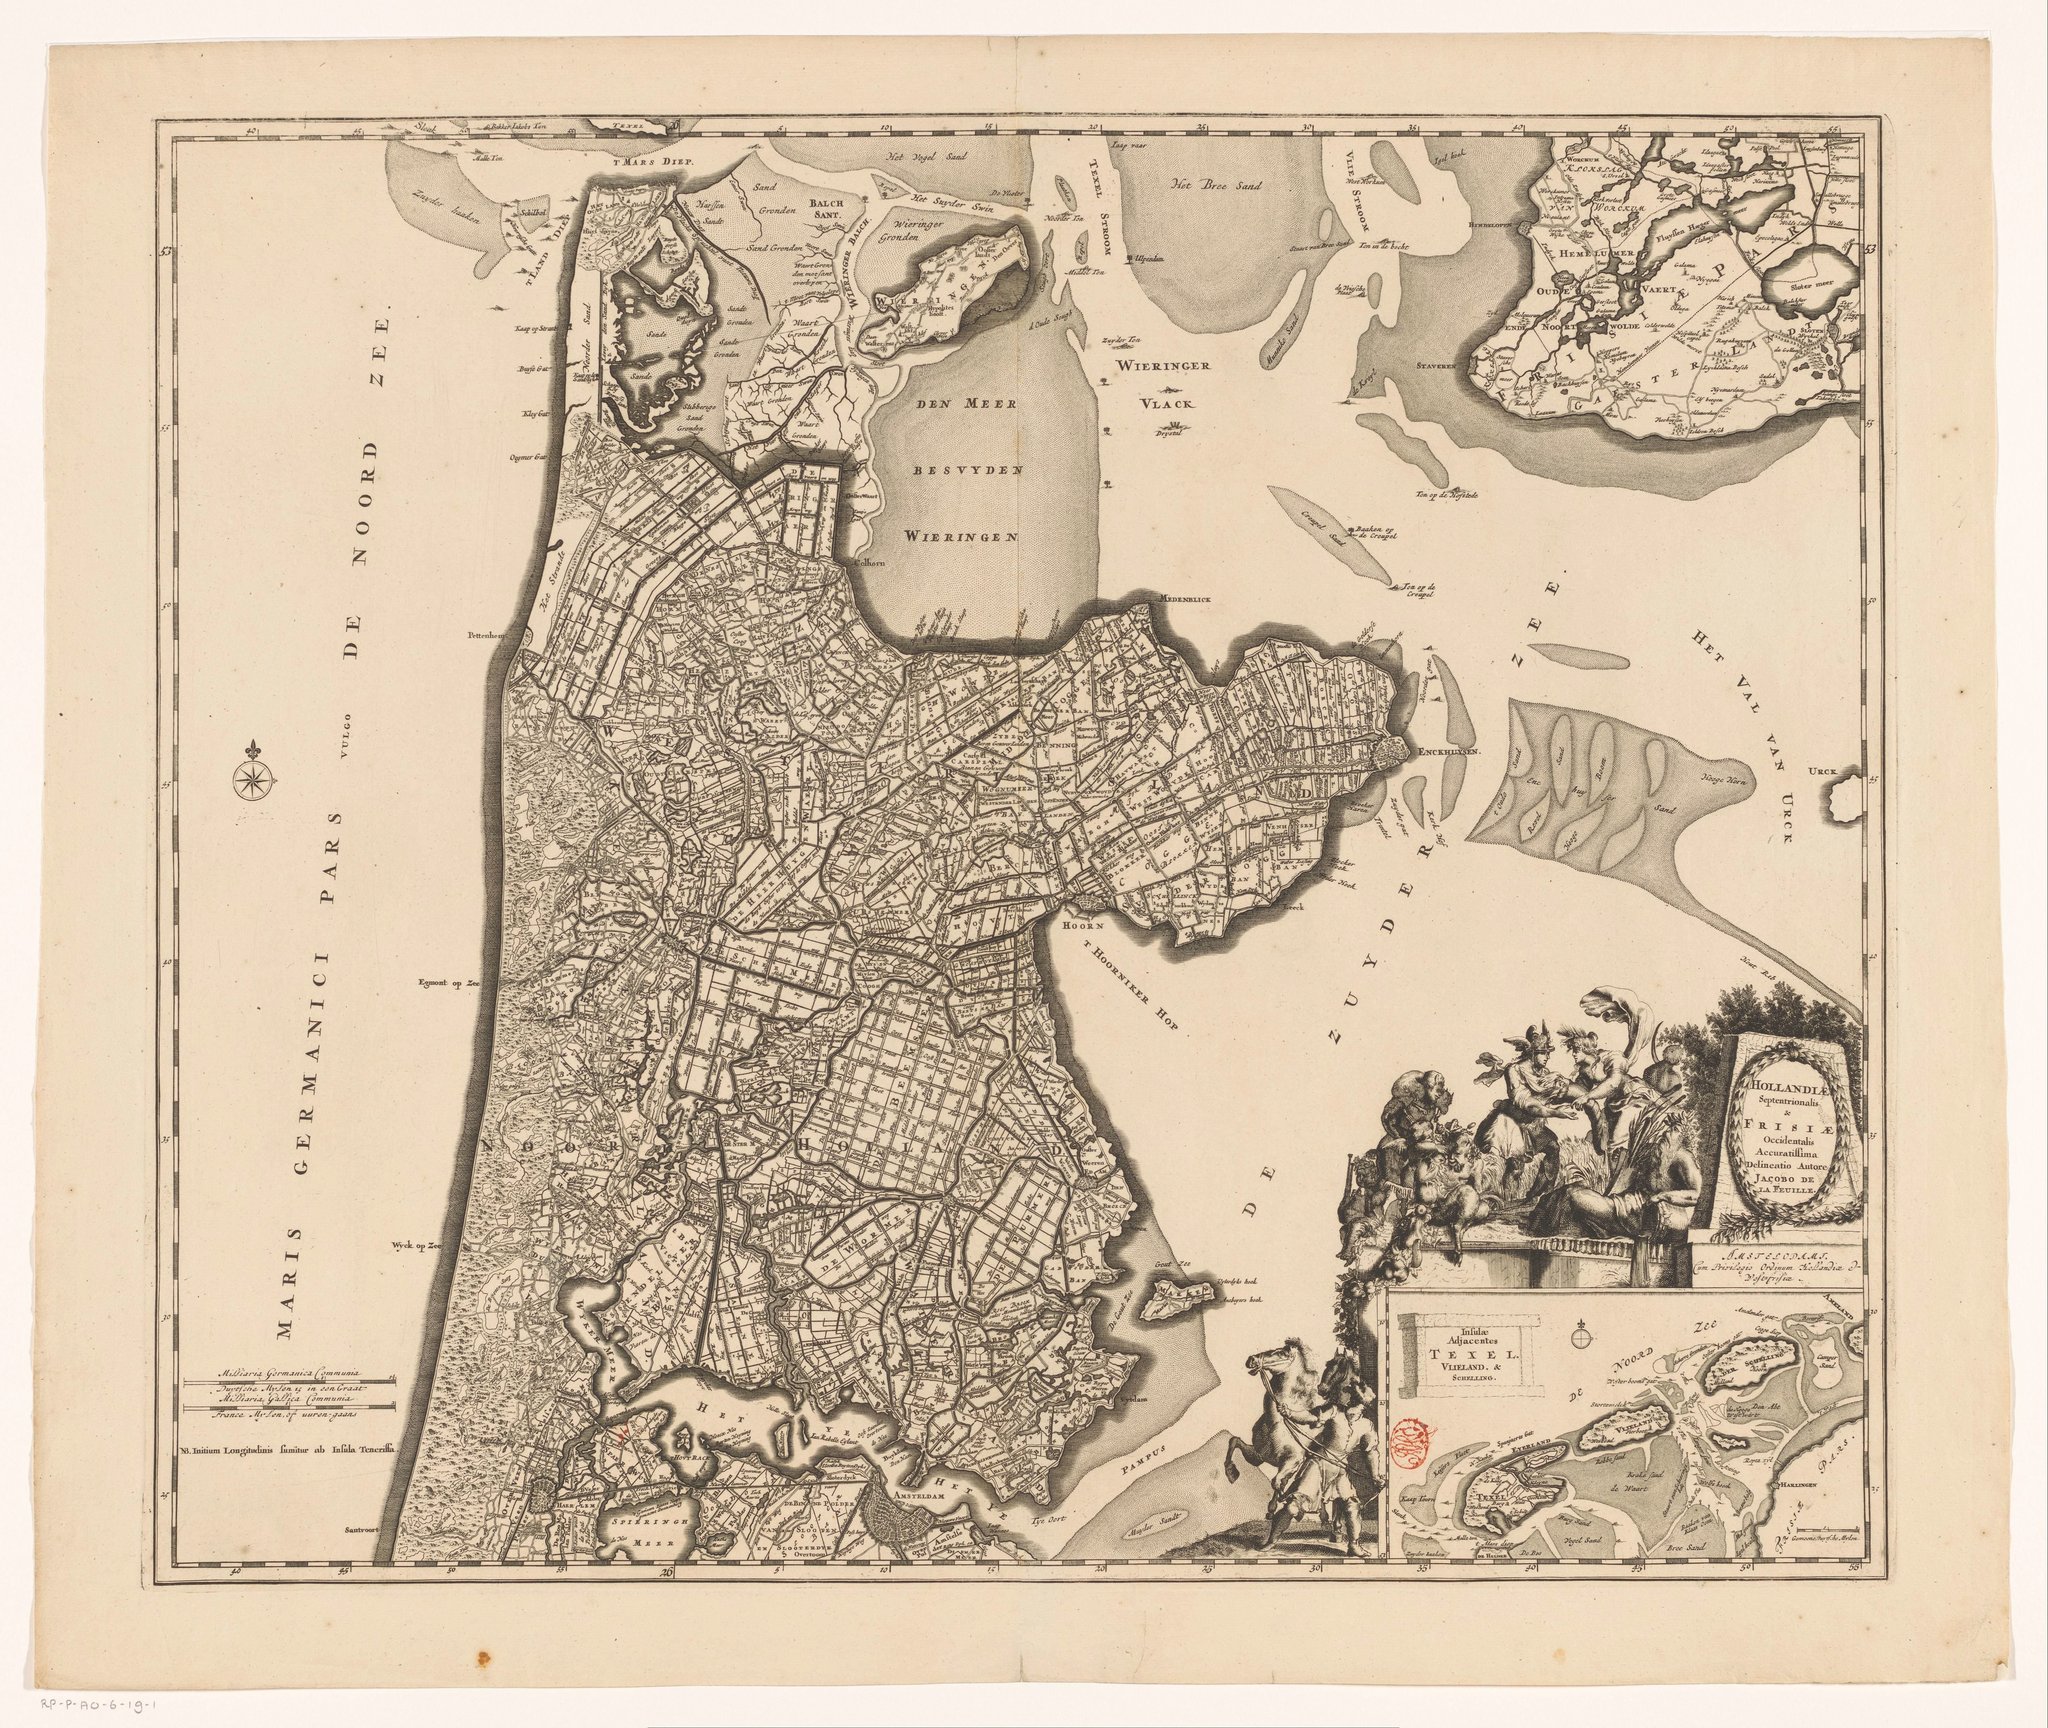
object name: print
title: Hollandiae septentrionalis & Frisiae occidentalis accuratissima delineatio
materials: paper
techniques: engraving, etching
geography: amsterdam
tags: 'cornucopia', horn of plenty, maps of separate countries or regions, (story of) mercury (hermes), river-gods, satyr(s) (in general)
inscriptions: collector's mark: Lugt 195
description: Linksonder twee schaalstokken: Milliaria Germanica communia / Duytsche mylen 15 in een graat; Milliaria Gallica communia / France mylen, of uuren gaans. Rechtsonder de titelcartouche met daaromheen verschillende figuren waaronder een man met een paard, saters, putti, Mercurius die de hoorn des overvloeds aanneemt van een vrouwfiguur, en een riviergod. Daaronder een inzetkaart van het Waddengebied met een schaalstok: Gemeene Duytsche mylen. Gradenverdeling langs de randen.